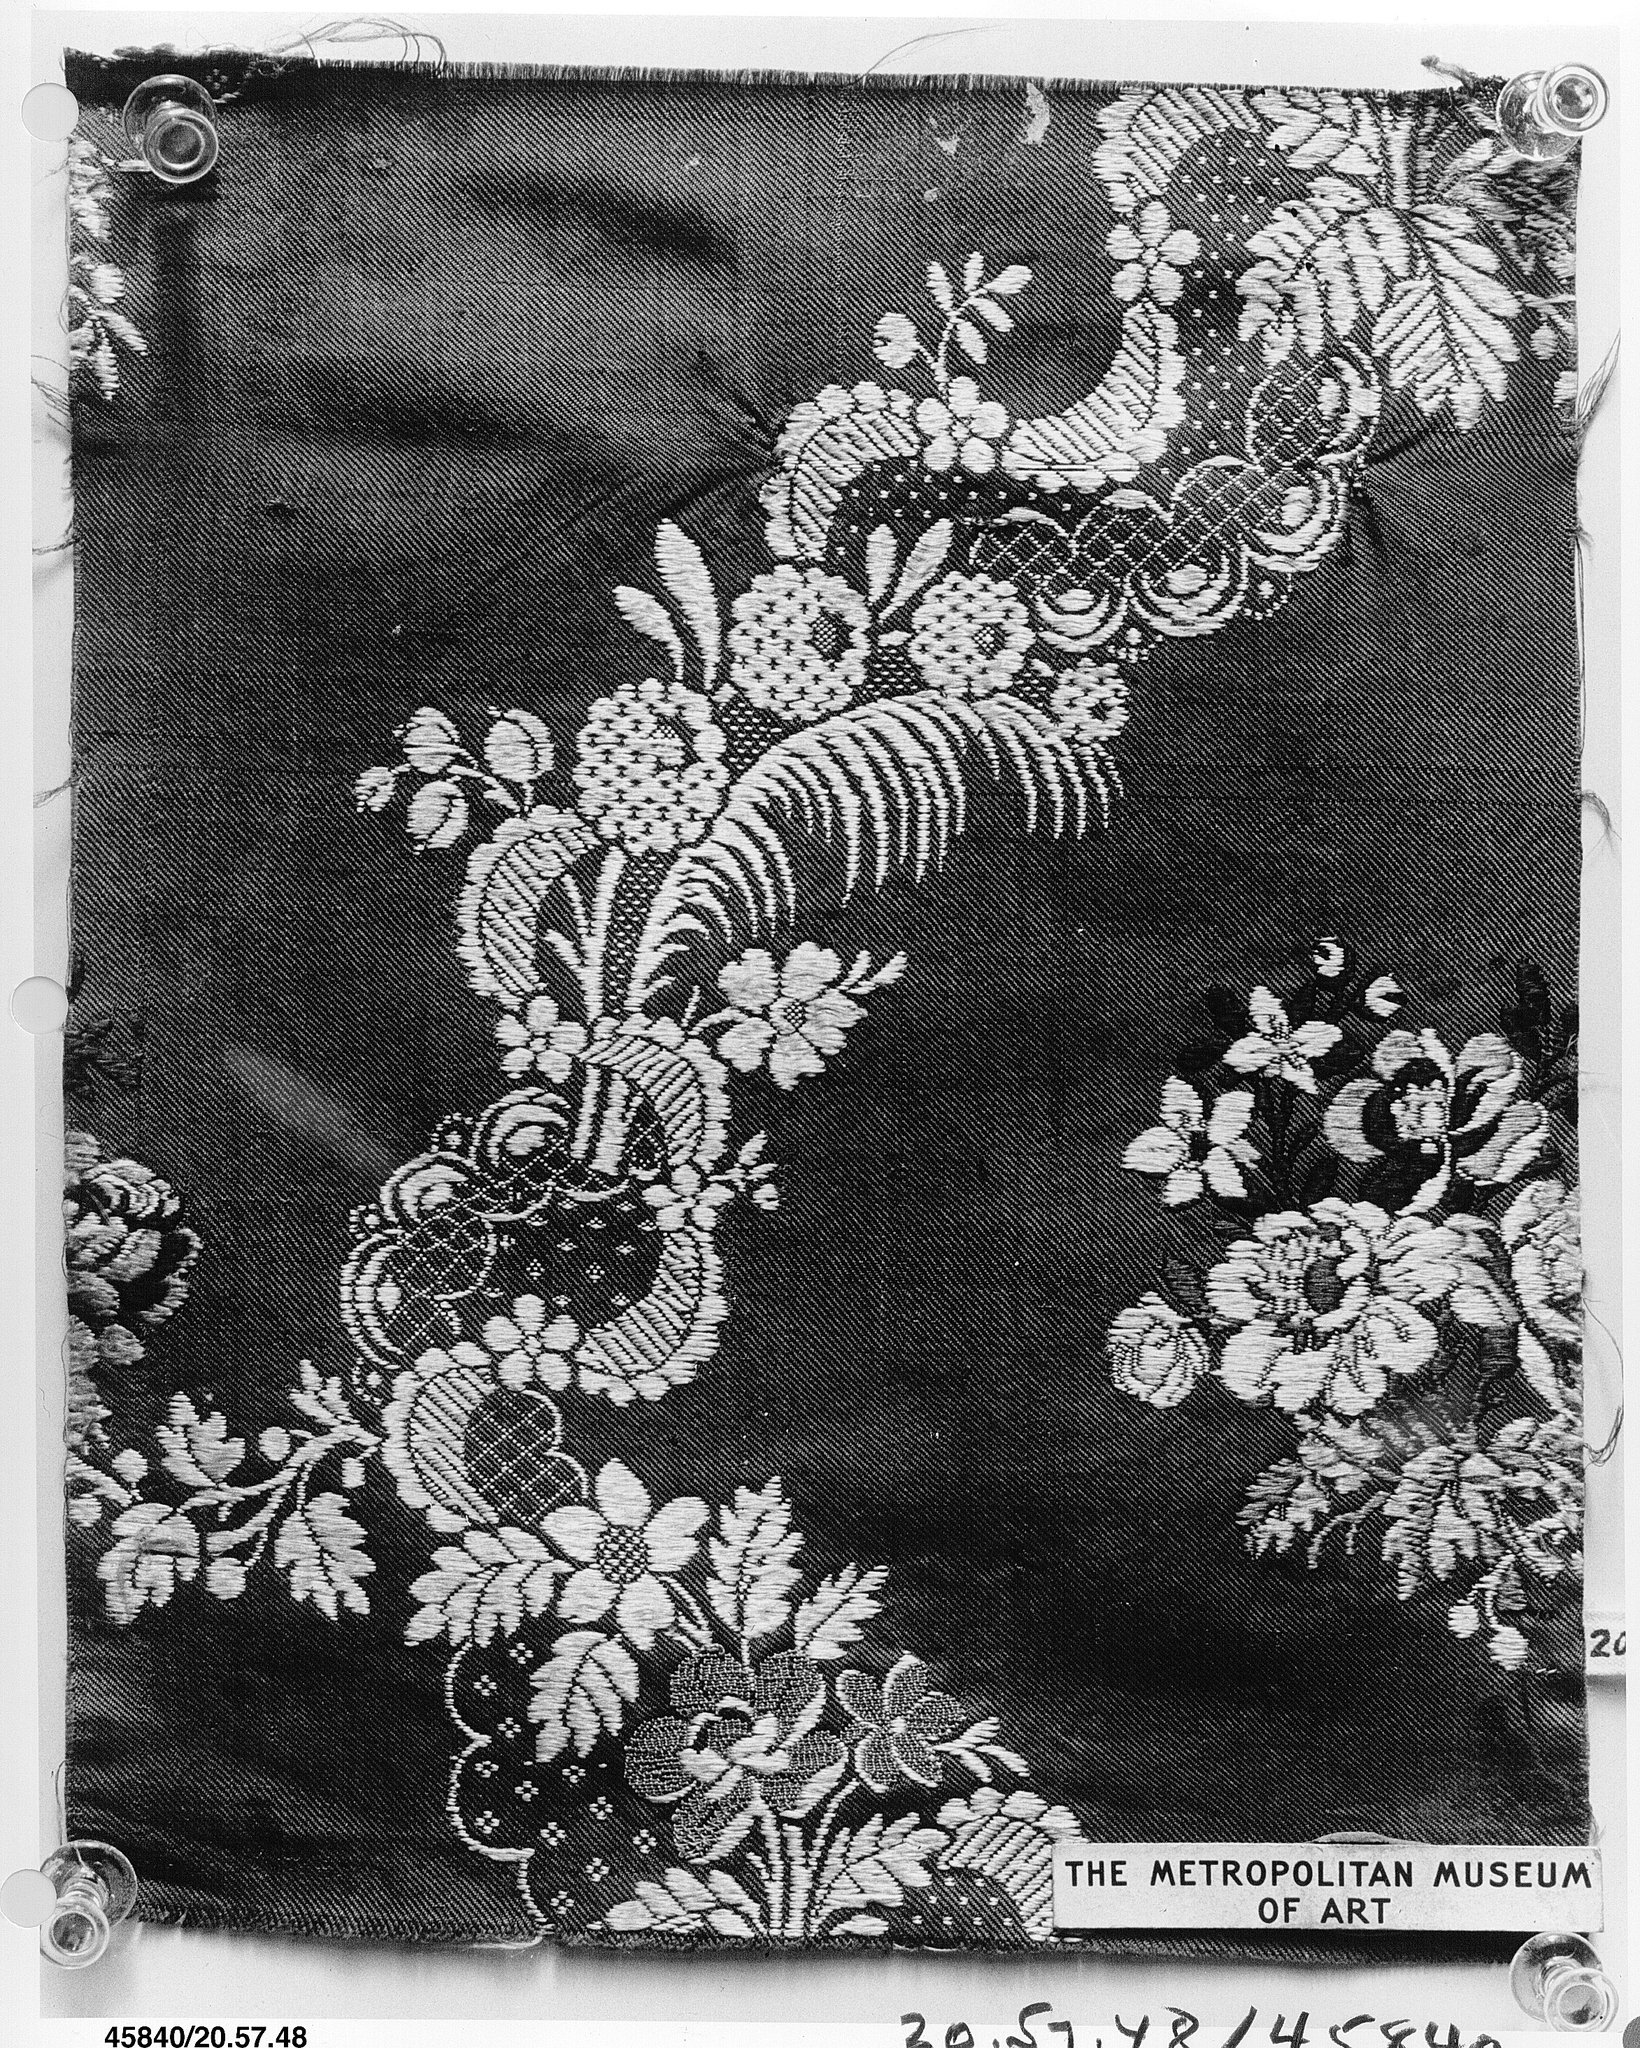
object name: piece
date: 1750-1775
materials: silk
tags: flowers,leaves